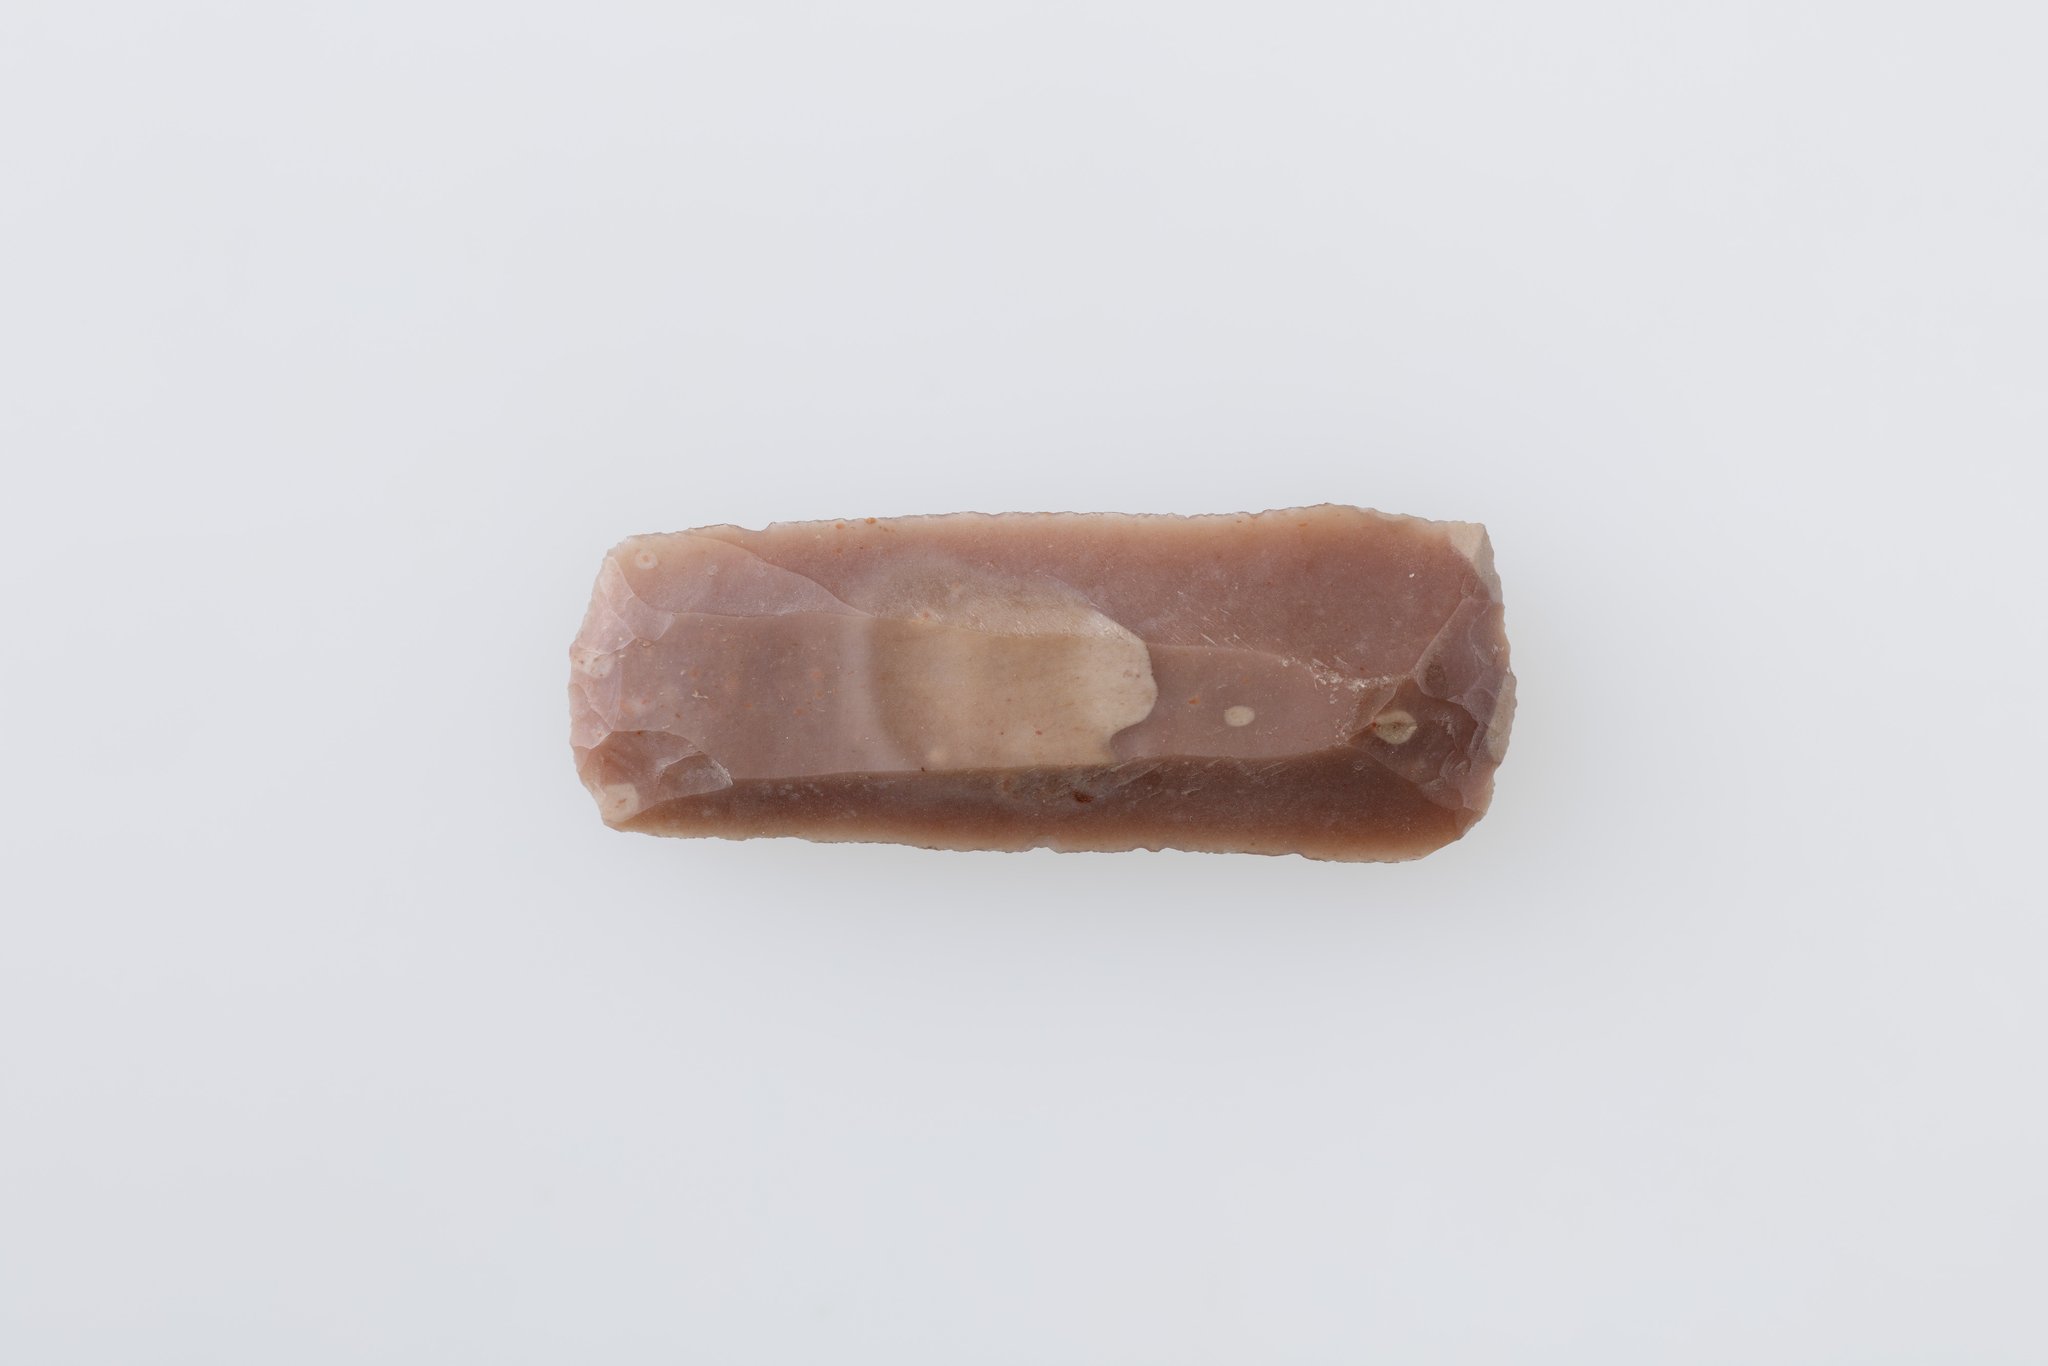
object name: tool, razor blade, scraper, truncaiton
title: Bi-truncated Blade Tool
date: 3100-2649 BCE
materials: stone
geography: egypt